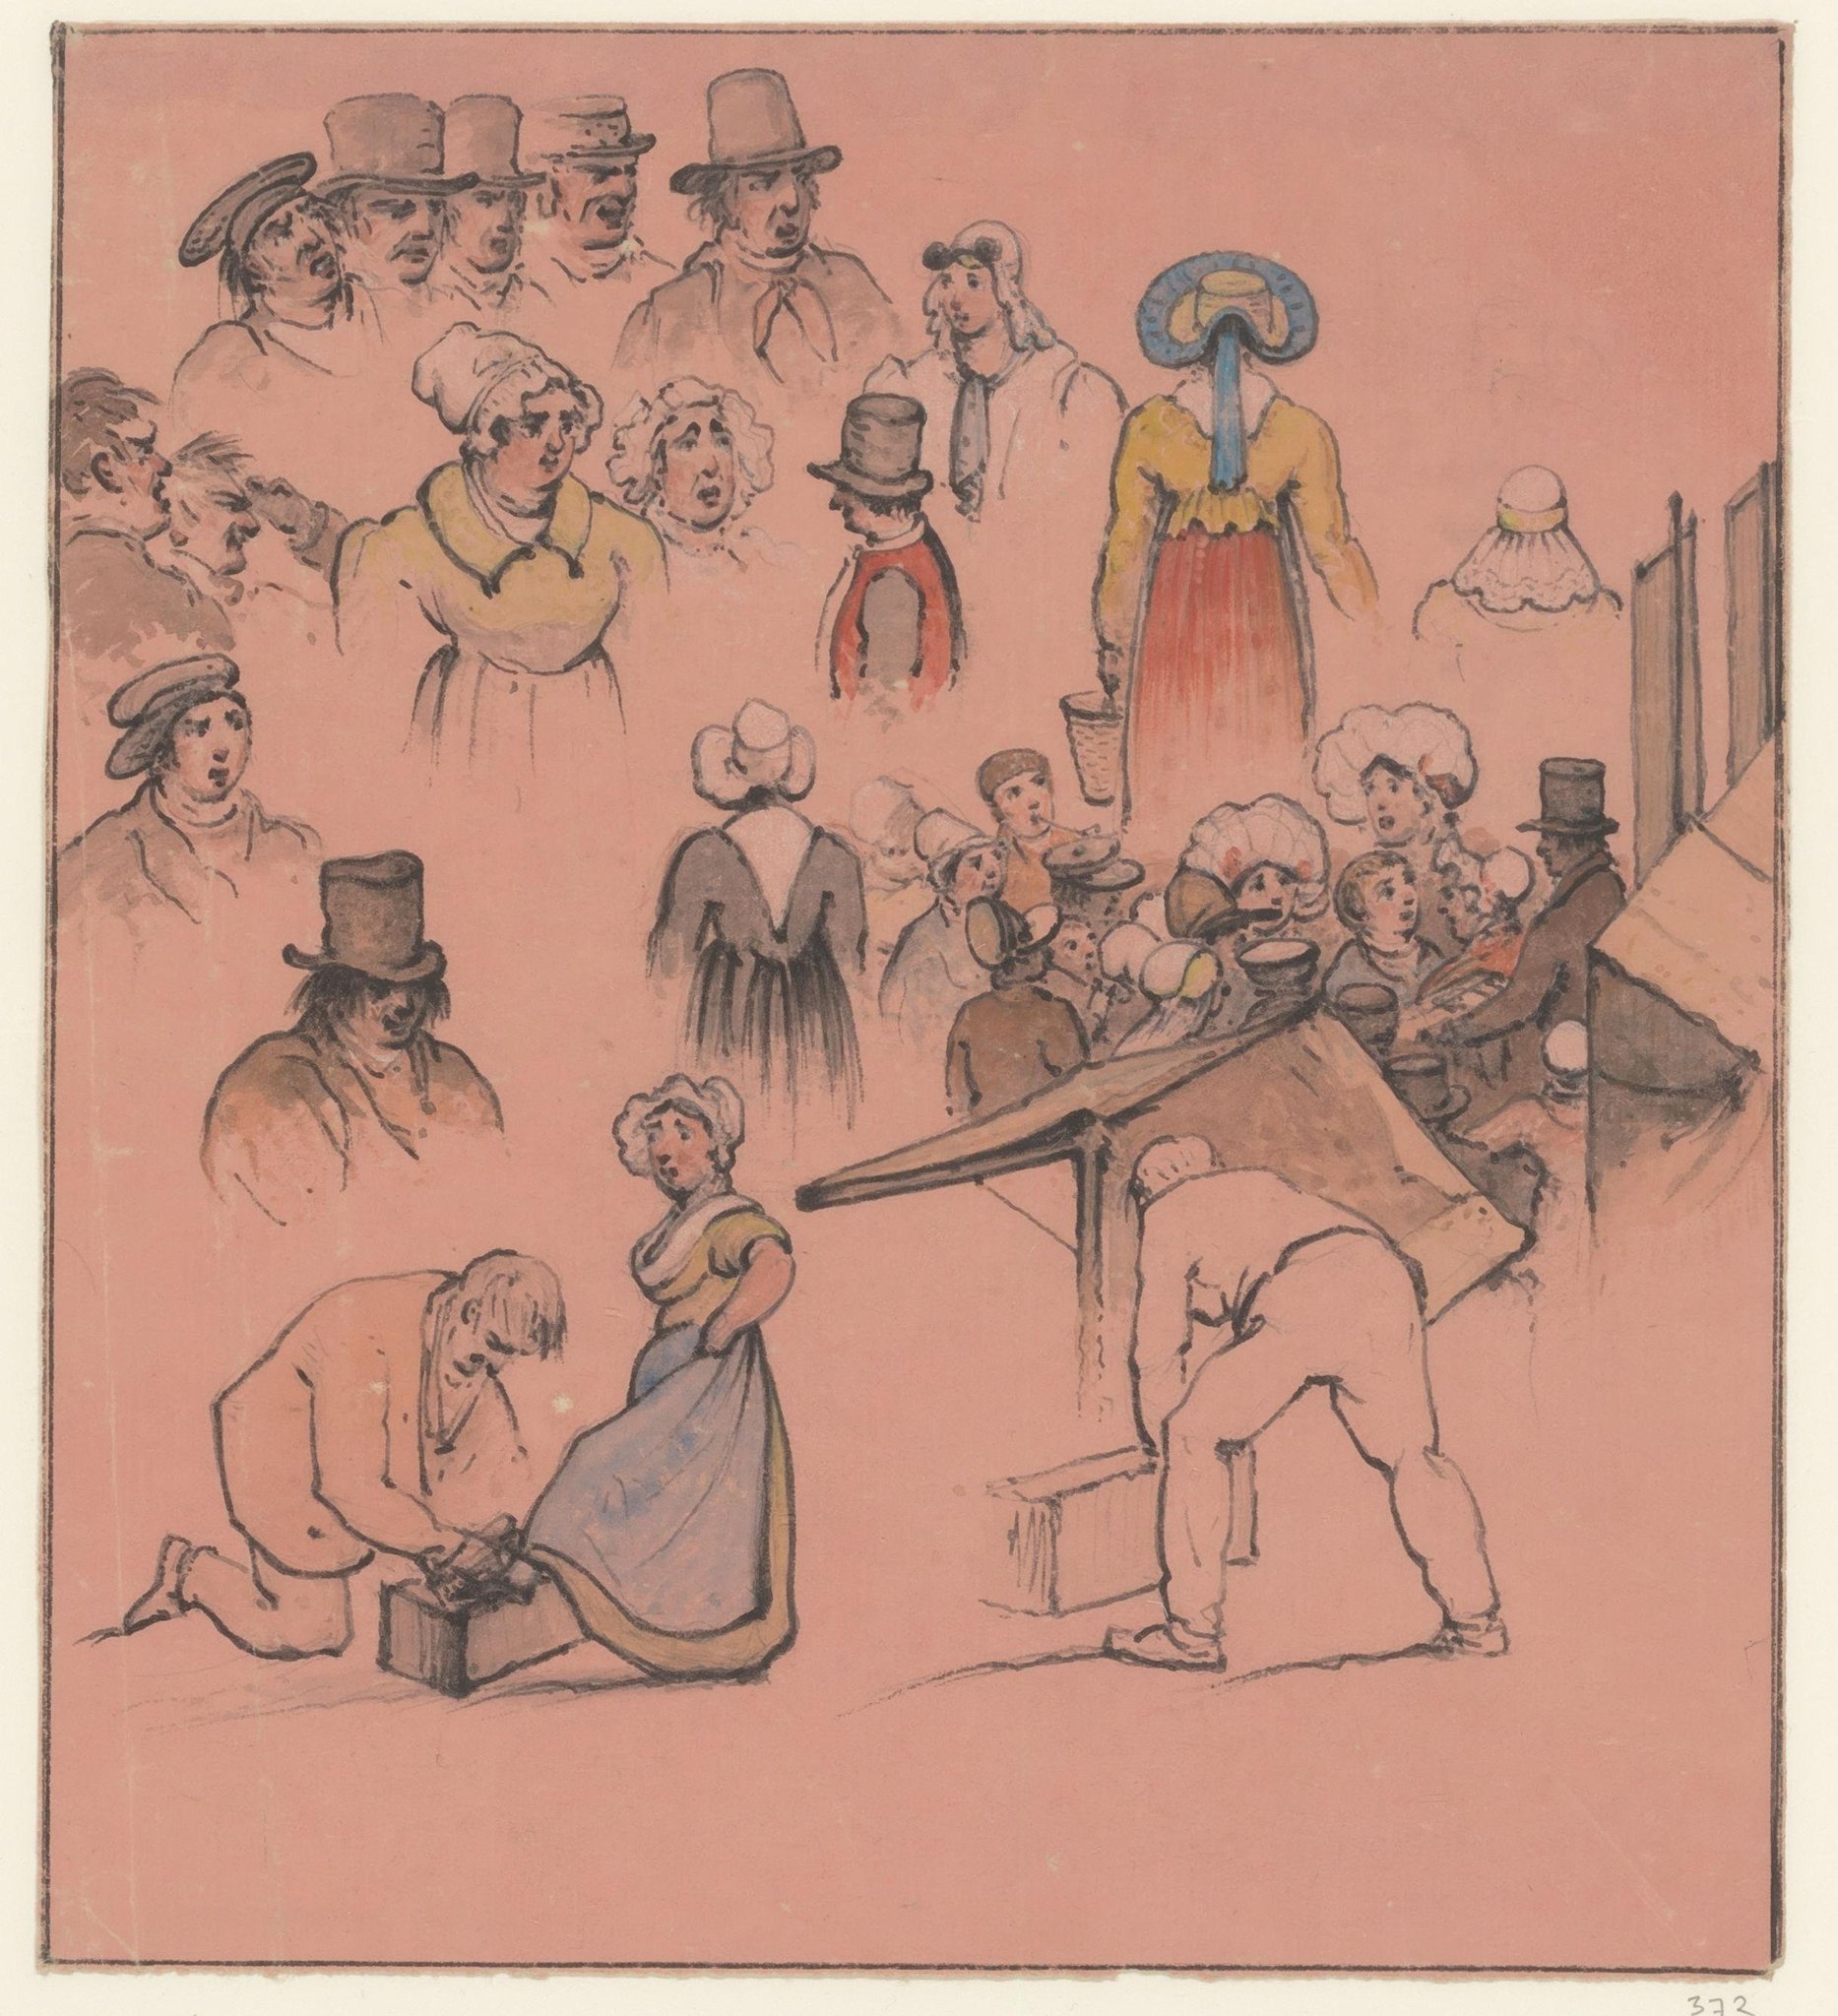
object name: drawing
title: Schetsblad met verschillende stadstypen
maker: christiaan andriessen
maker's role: draughtsman, print maker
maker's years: 1775-1846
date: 1785-1846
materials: paint, ink, paper, watercolor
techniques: brush, pen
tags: orphanage, shoe-maker, cobbler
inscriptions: collector's mark: Lugt 1641, stamp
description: Schetsblad met verschillende stadstypen, met onder andere kinderen van het burgerweeshuis en een man die de schoenen van een vrouw poetst. Onderwerpsrubrieken binnen de Atlas Zeden en Gewoonten: Zeden en Gewoonten in Engeren Zin, De Kleeding, Kleederdrachten (tijdvakken), Het begin der 19de eeuw. Teekeningen van Christiaan Andriessen, † 1819. mannen en vrouwen. stadstypen.